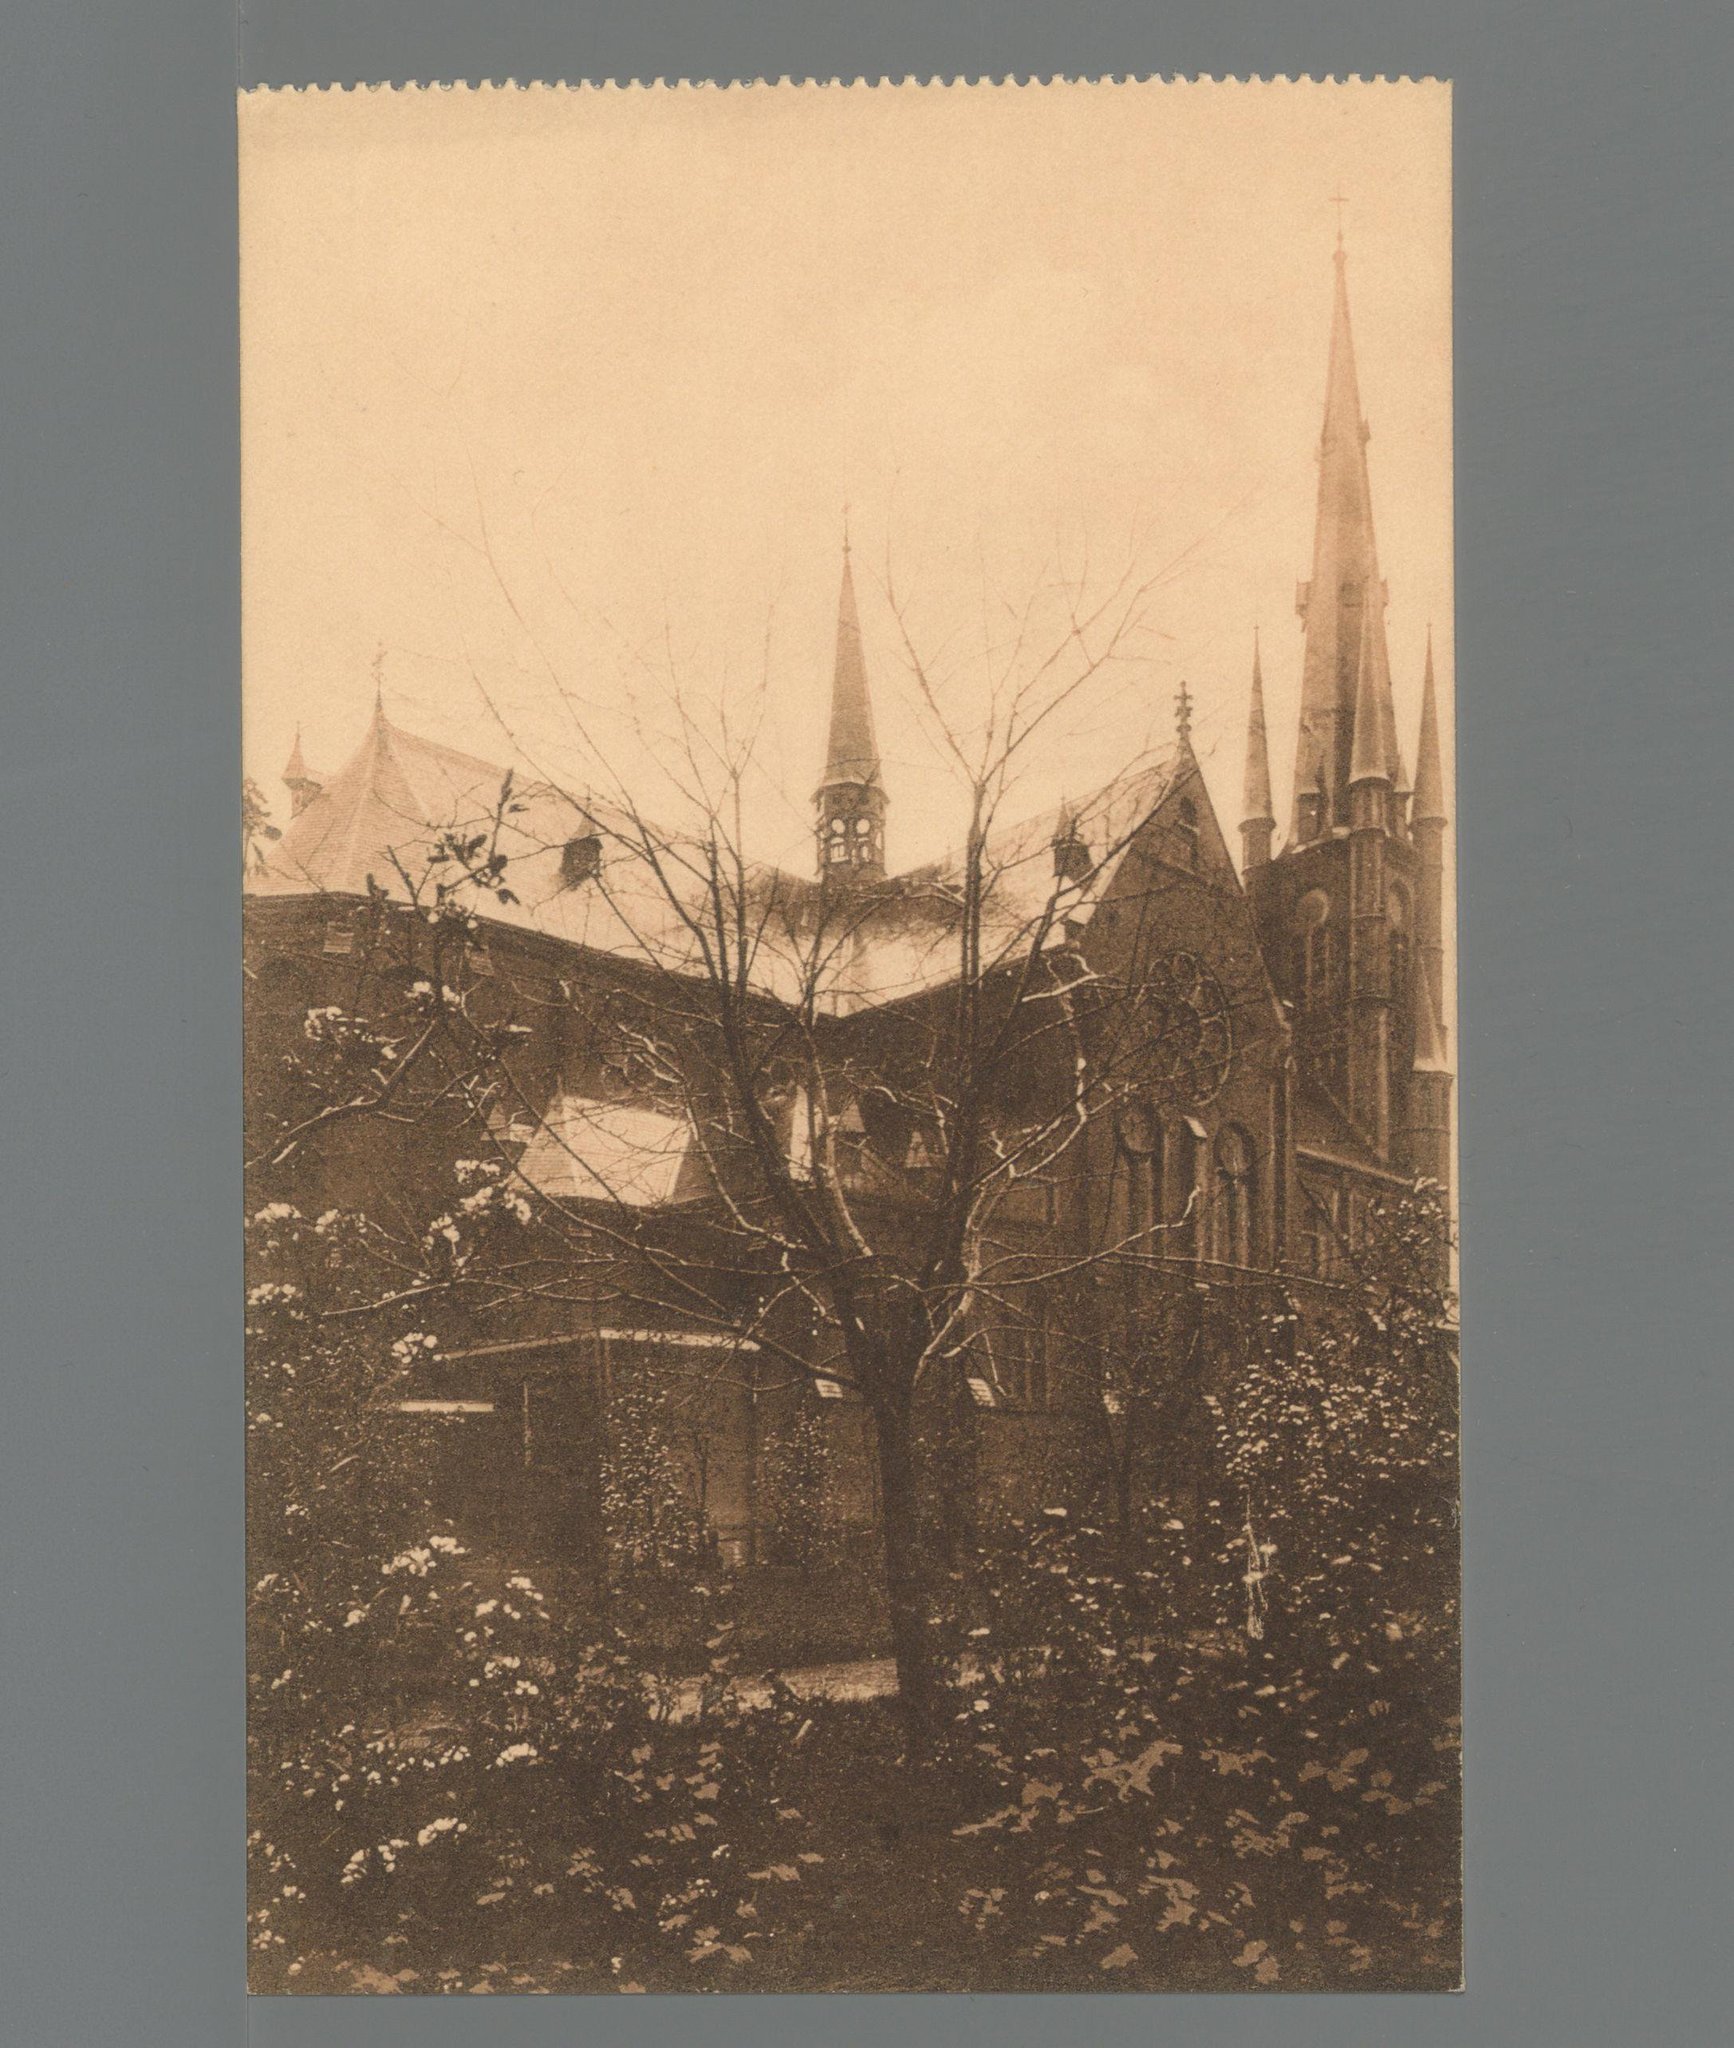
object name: photomechanical print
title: Bijkerk H. Monica, Utrecht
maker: Anonymous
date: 1905-1930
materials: cardboard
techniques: photograph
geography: utrecht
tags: church (exterior)